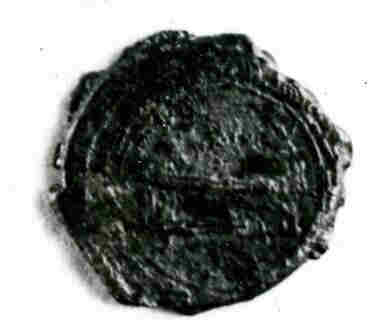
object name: coin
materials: copper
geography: iran